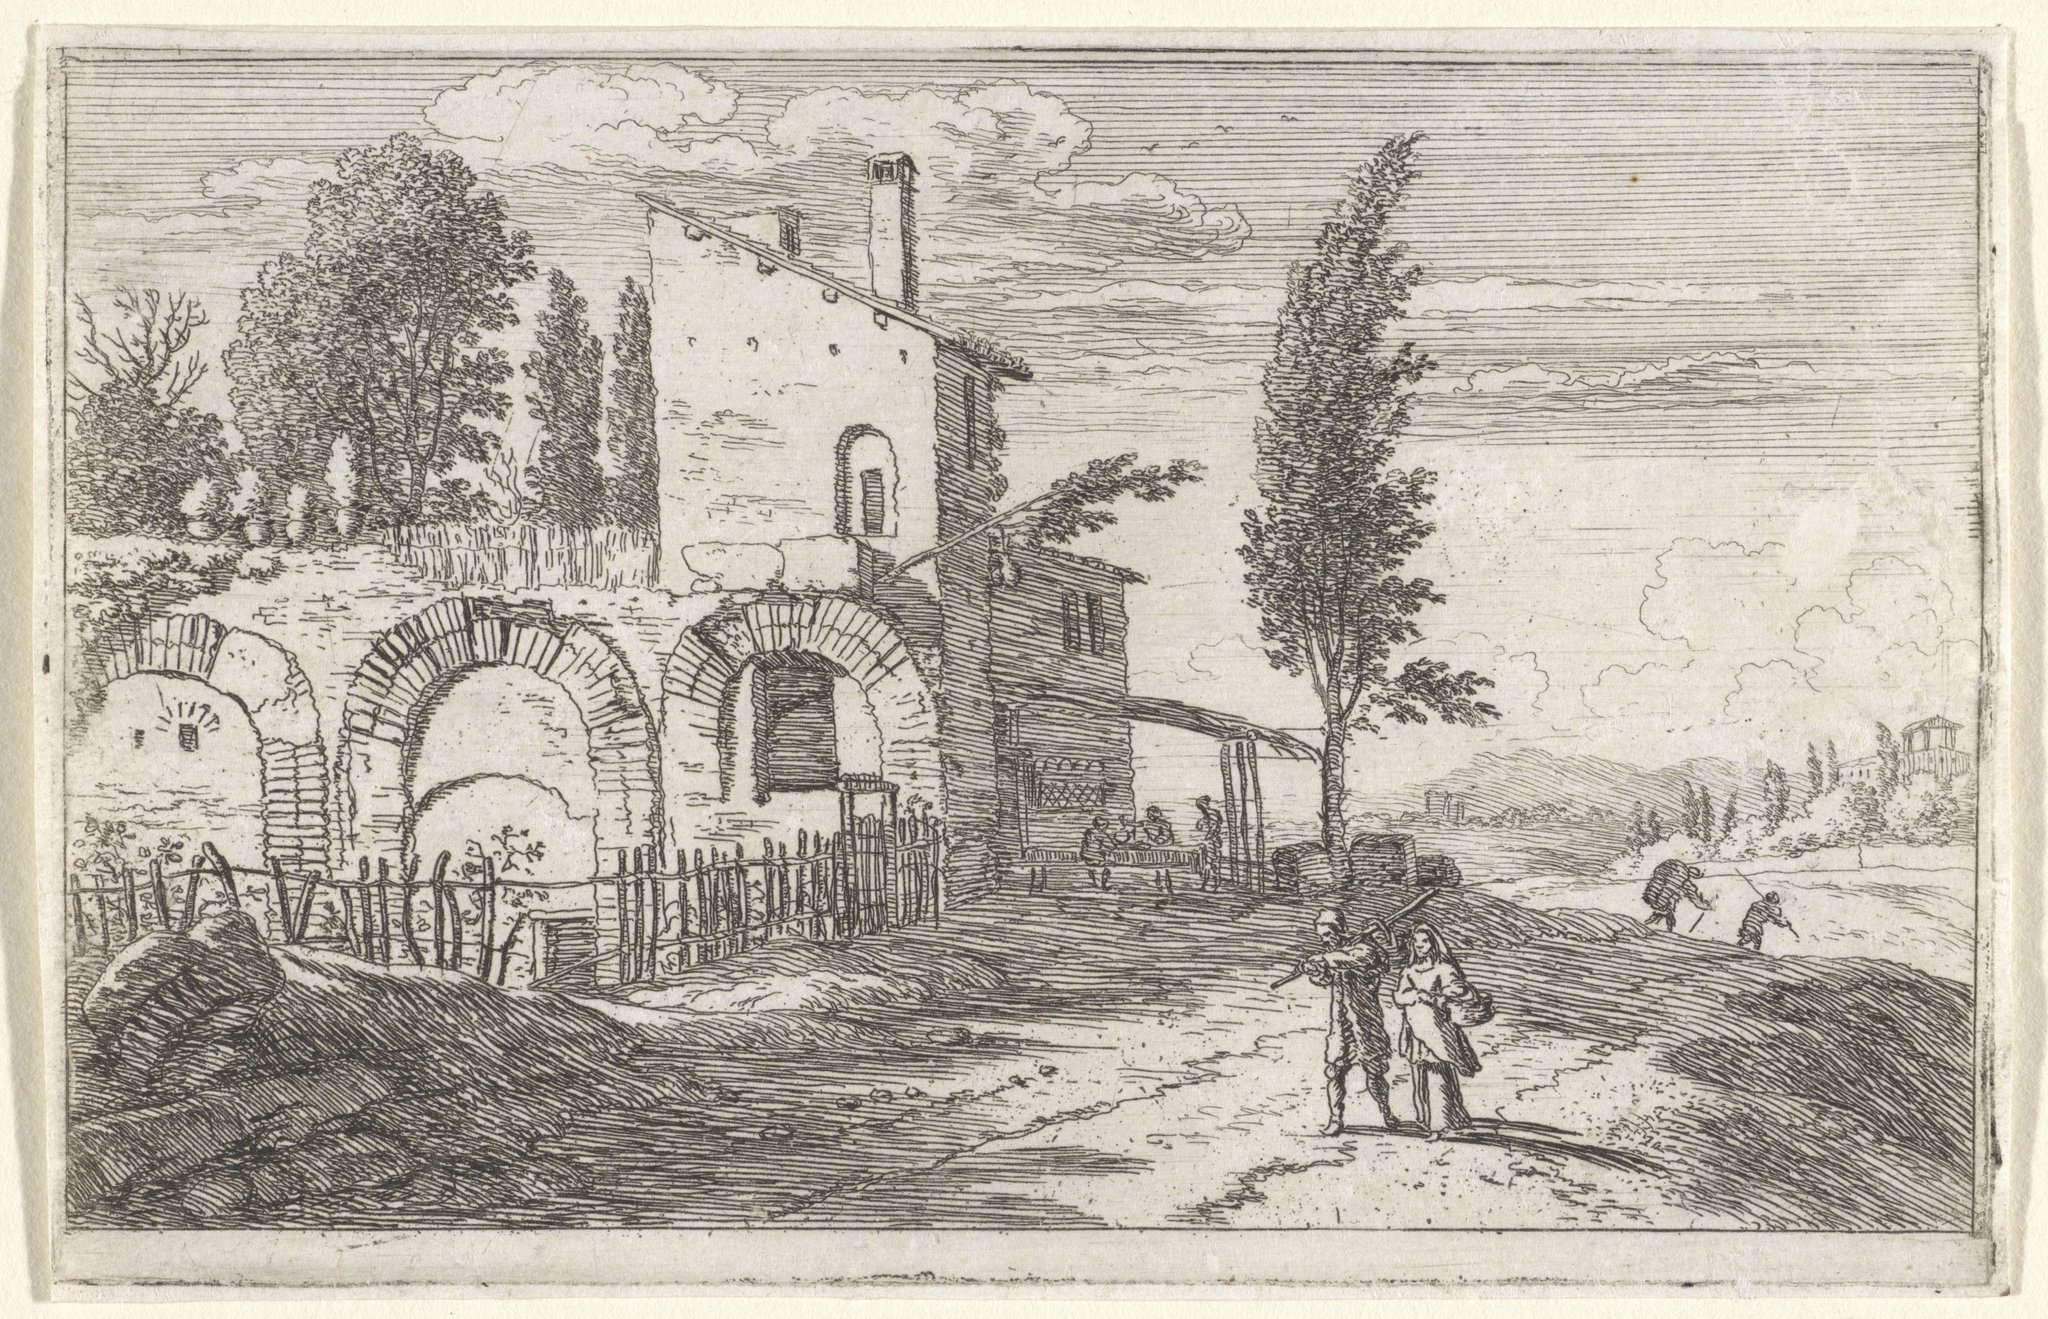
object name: print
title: Titelblad en twaalf gezichten op Rome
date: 1629-1655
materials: paper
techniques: etching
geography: rome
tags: landscapes, inn, coffee-house, public house, etc., landscape with ruins, ruin of a dwelling, house, castle, etc., rome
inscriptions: collector's mark: Lugt 240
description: Wandelaars lopen langs een herberg die gevestigd is in de ruïnes van het keizerlijk paleis in (de directe omgeving van) Rome.